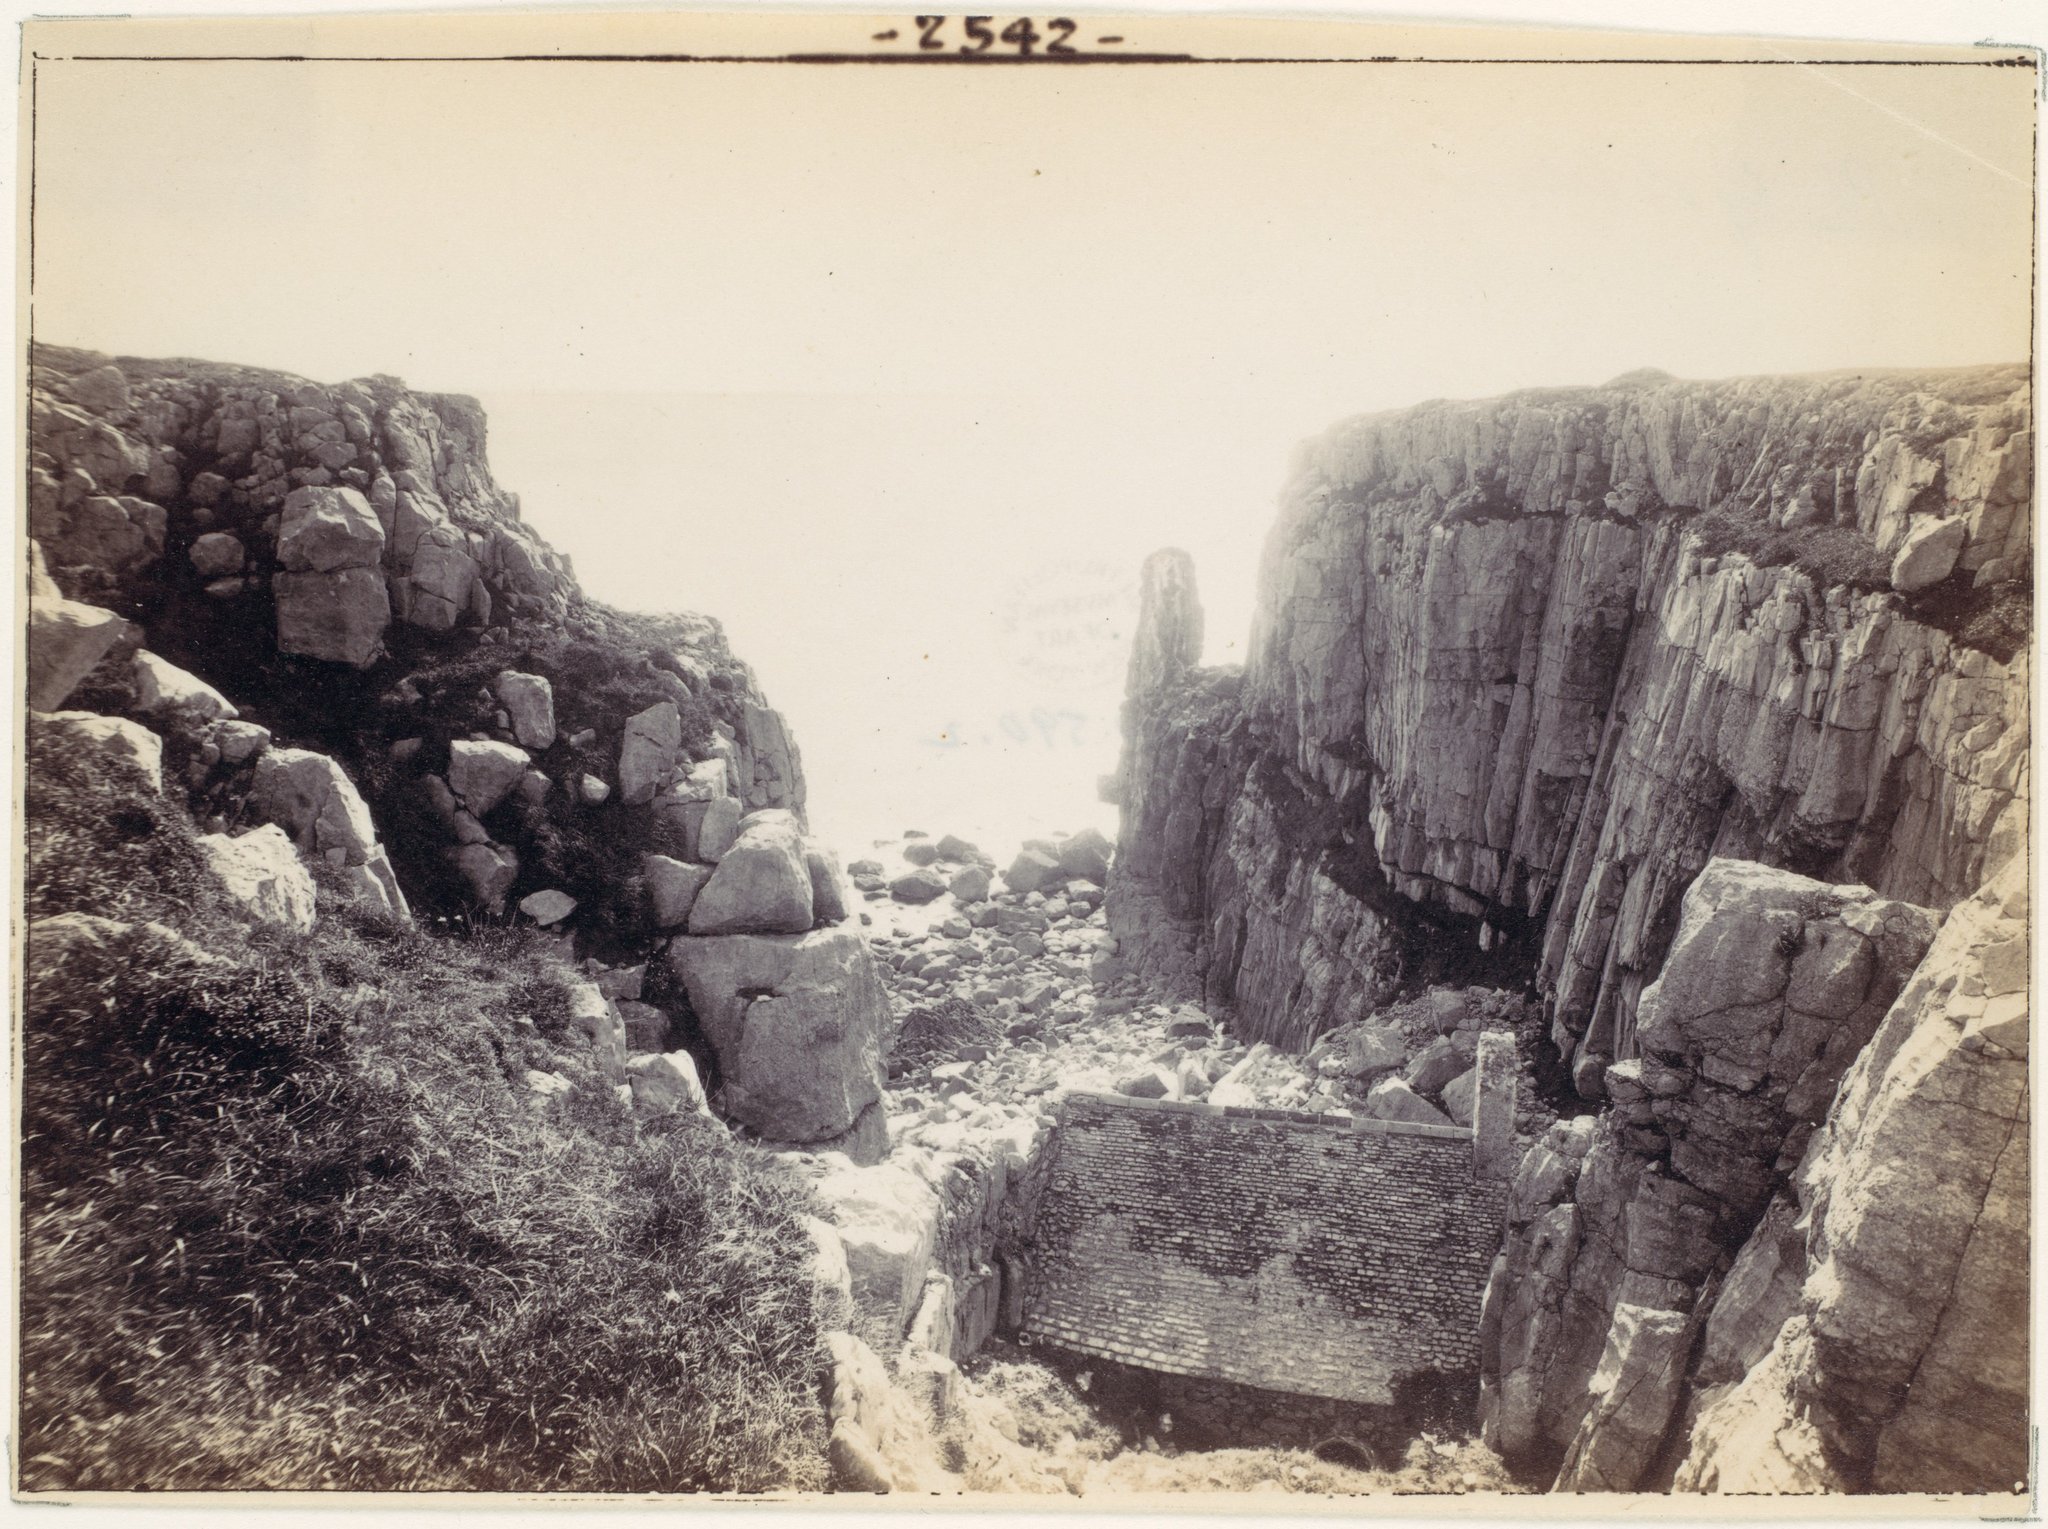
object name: photograph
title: [Rocky Inlet with Seascape]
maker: francis bedford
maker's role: artist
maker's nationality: british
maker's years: 1816-1894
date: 1870-1879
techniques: albumen silver print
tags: seascapes